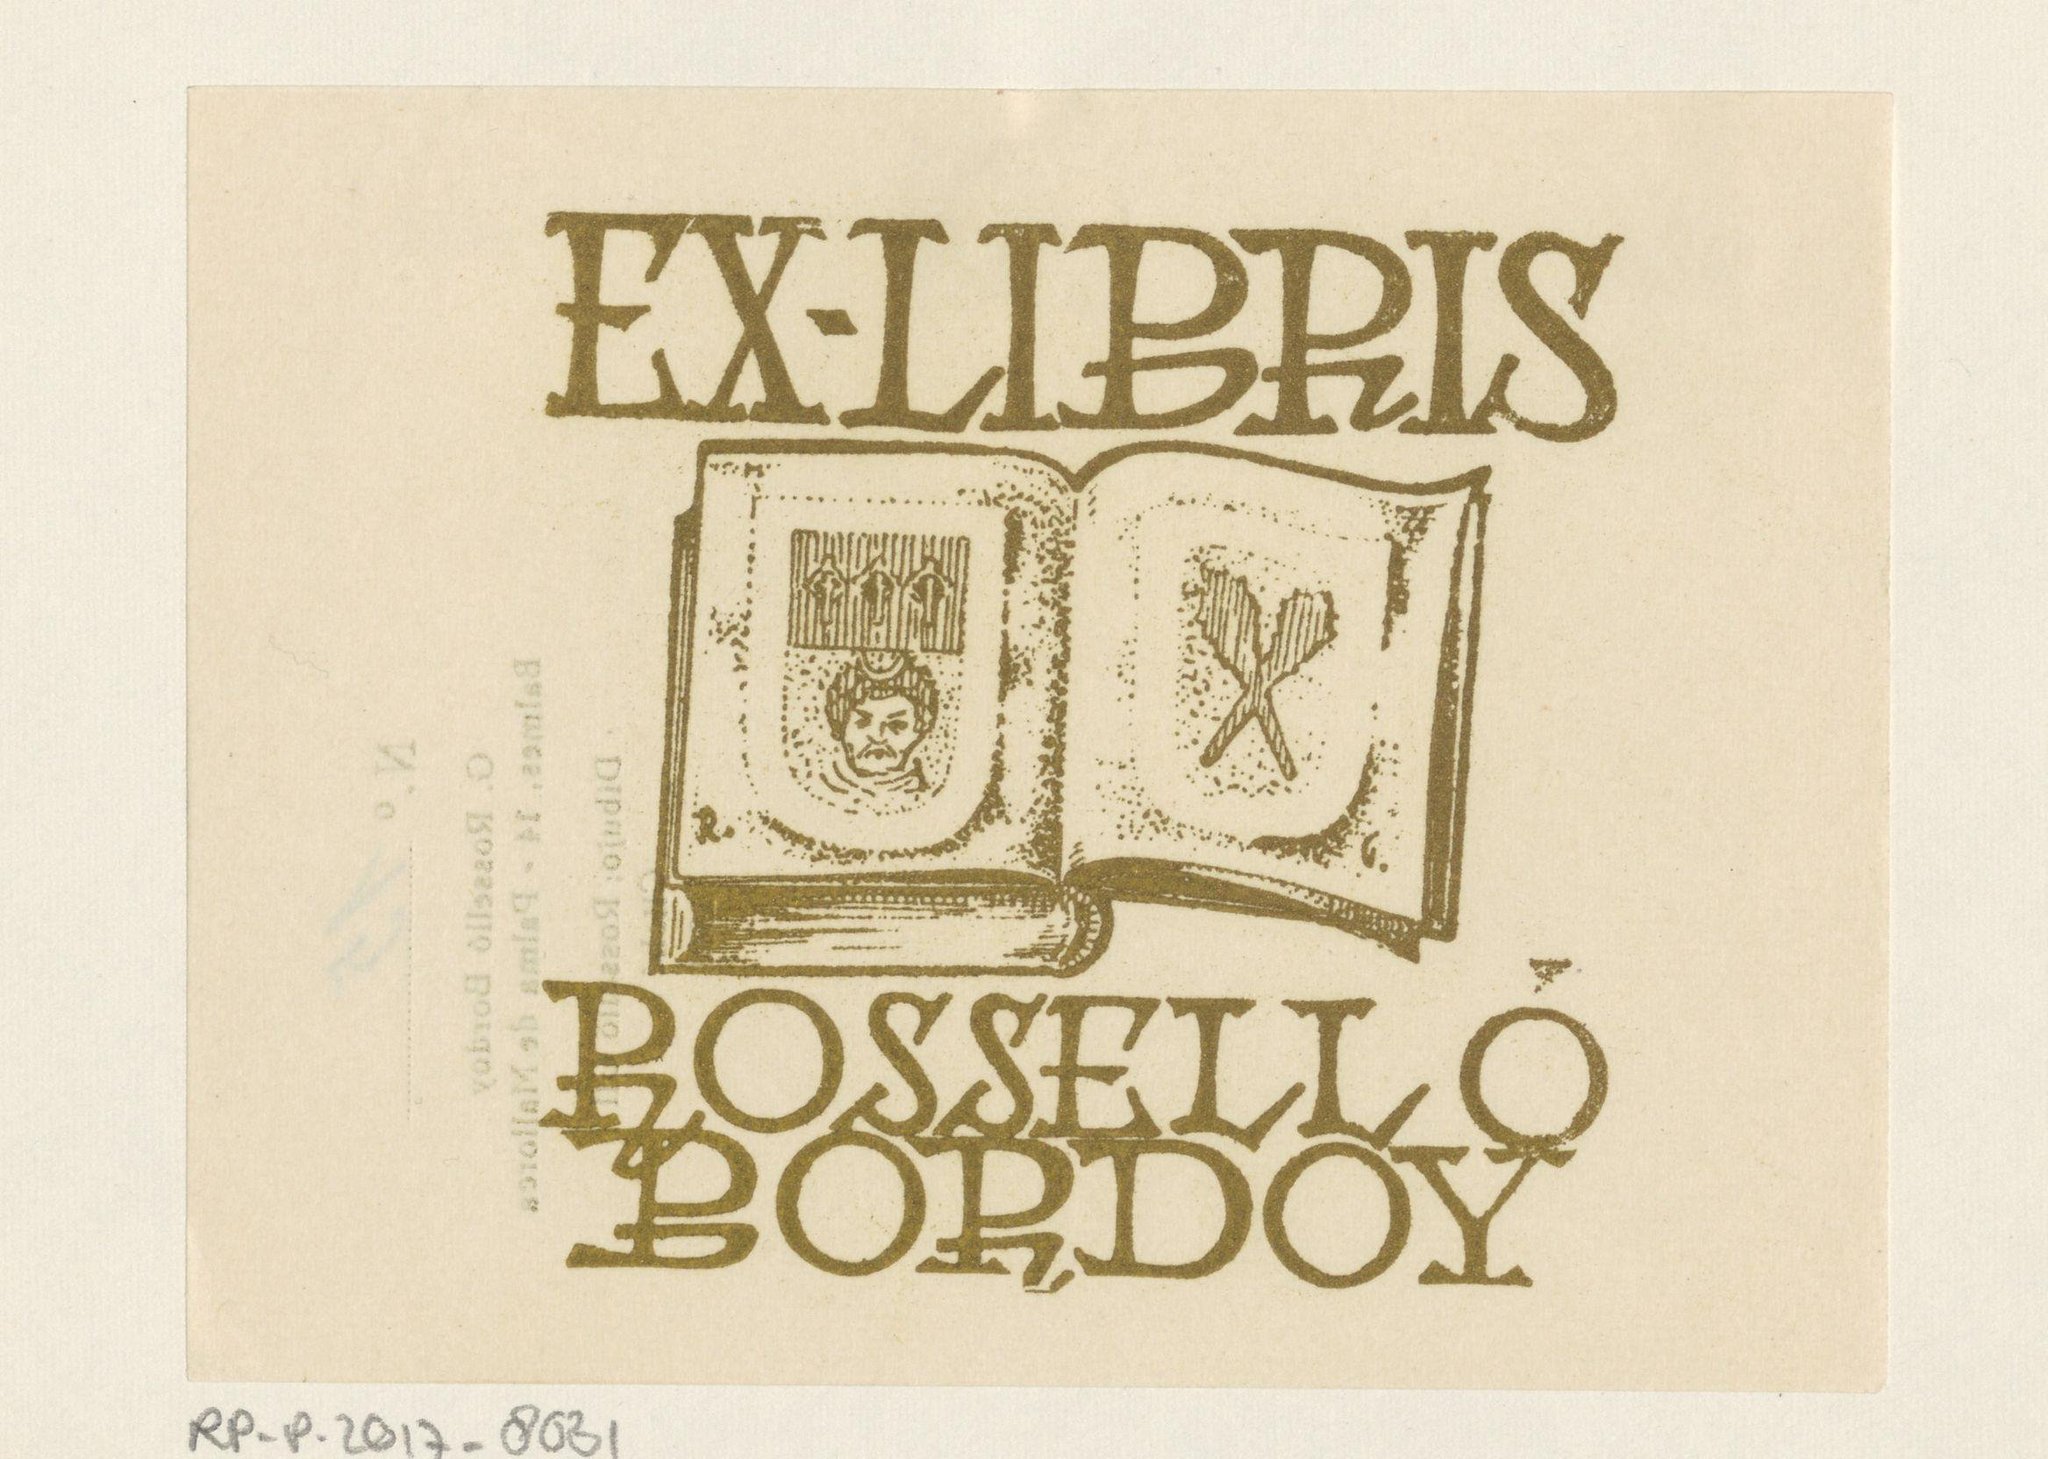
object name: bookplate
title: Ex libris van G. Rosselló Bordoy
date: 1950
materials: paper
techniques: printing block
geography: spain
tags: book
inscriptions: inscription: ‘No. 15/ G. Rosselló Bordoy/ Balmes, 14 - Palma de Mallorca/ Dibujo: Rosselló Gil/ Cliché/ 1950’